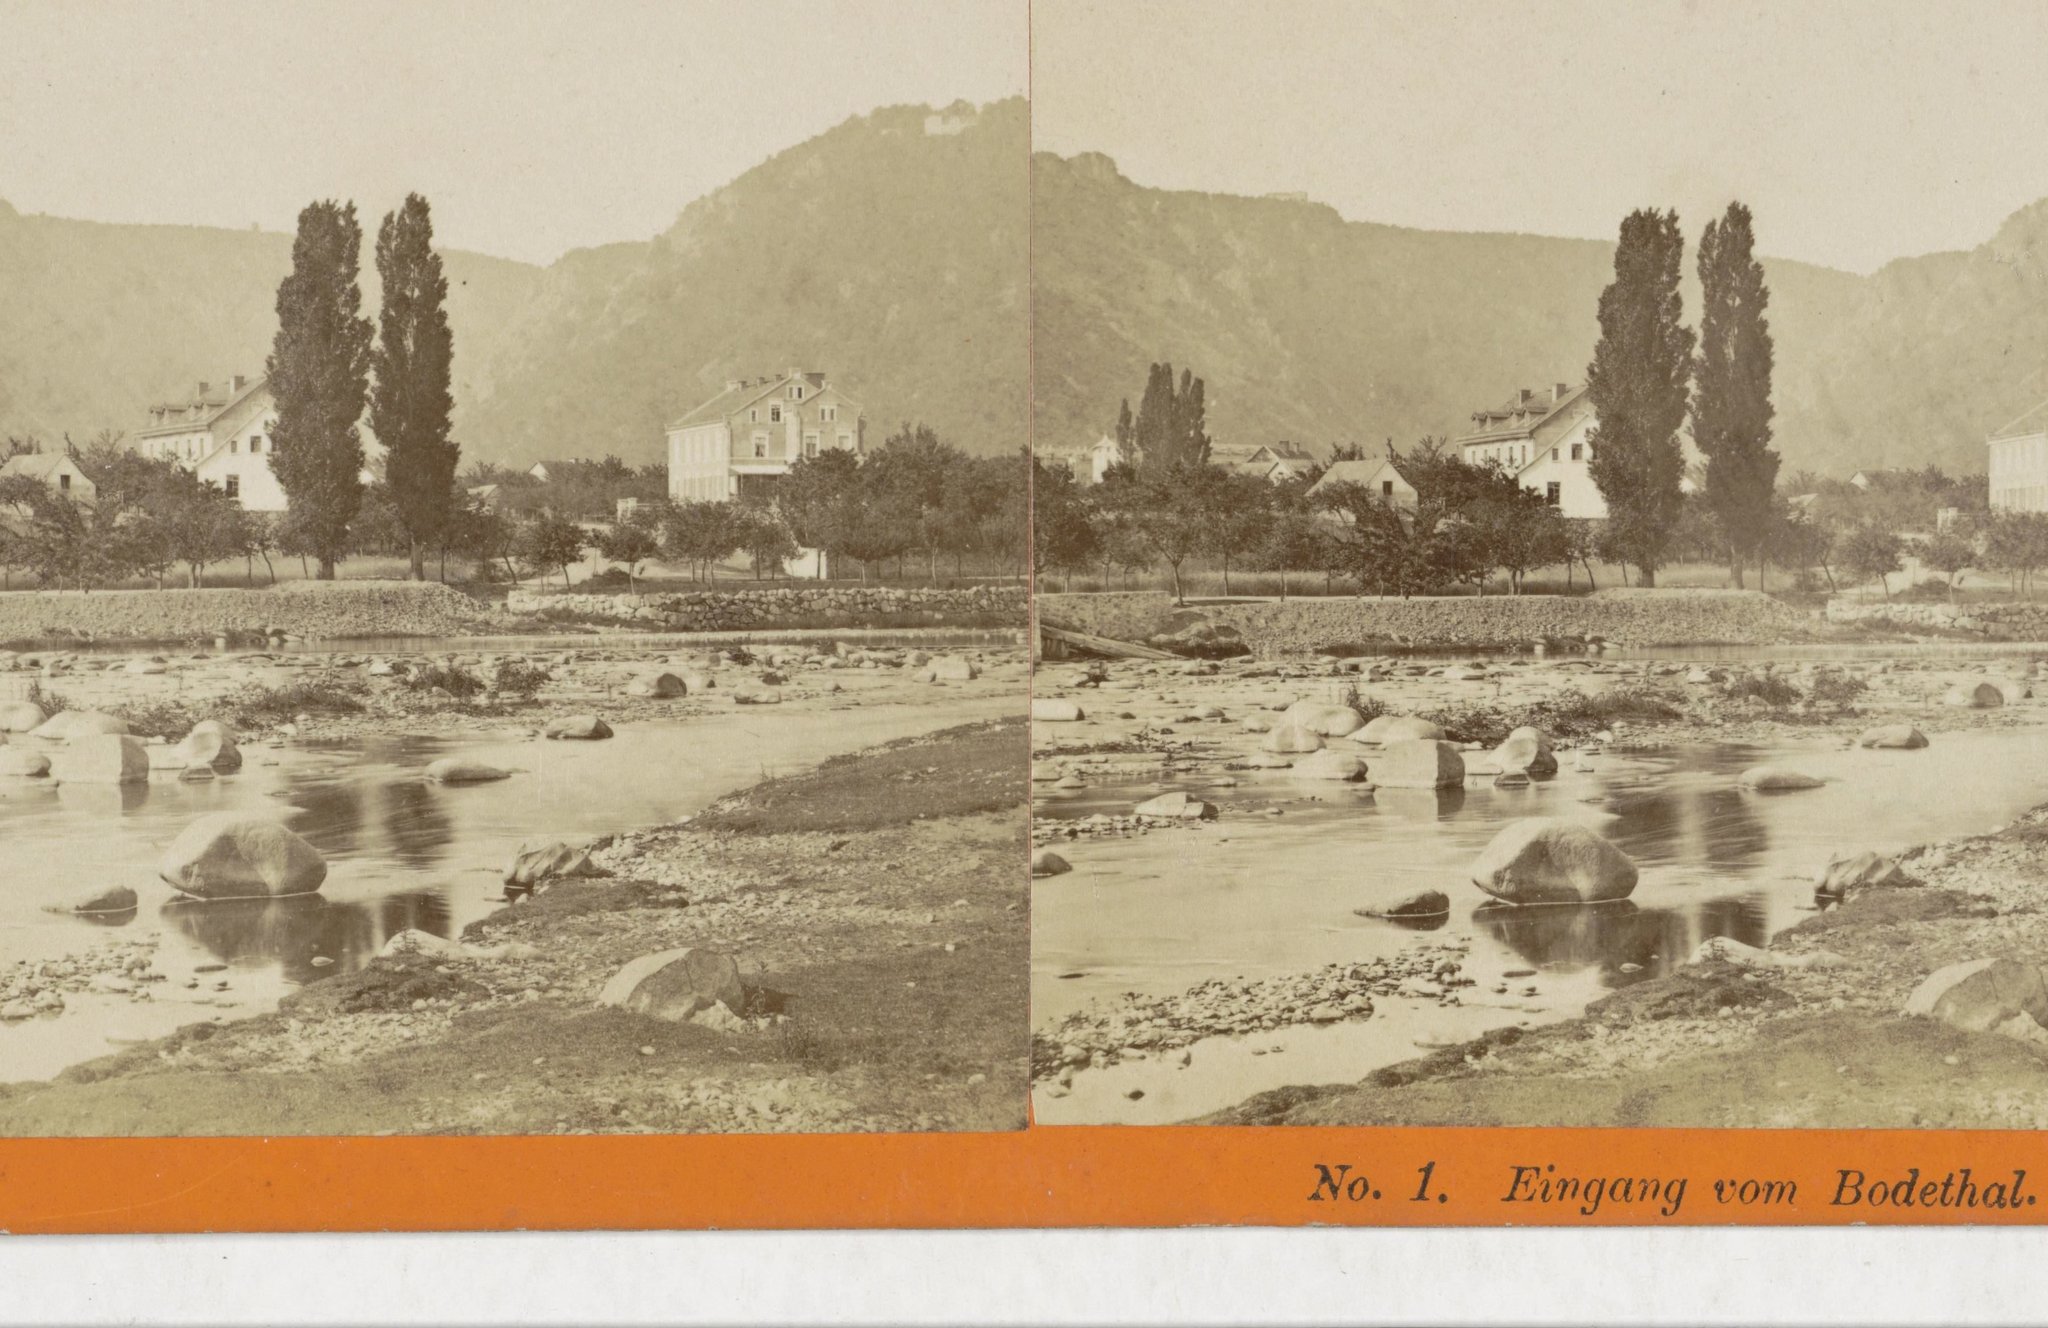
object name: stereograph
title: Begin van het Bodedal, Harz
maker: hermann selle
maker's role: fotograaf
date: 1868-1890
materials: cardboard, paper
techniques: albumen print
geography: berlin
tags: dale, valley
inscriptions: number: ‘No. 1.’, inscription: ‘No. 1. Harz: Eingang in's Bodenthal (...) dem Fluss.) (W. Riehl)’, inscription: ‘Hof-Photograph. Potsdam.’